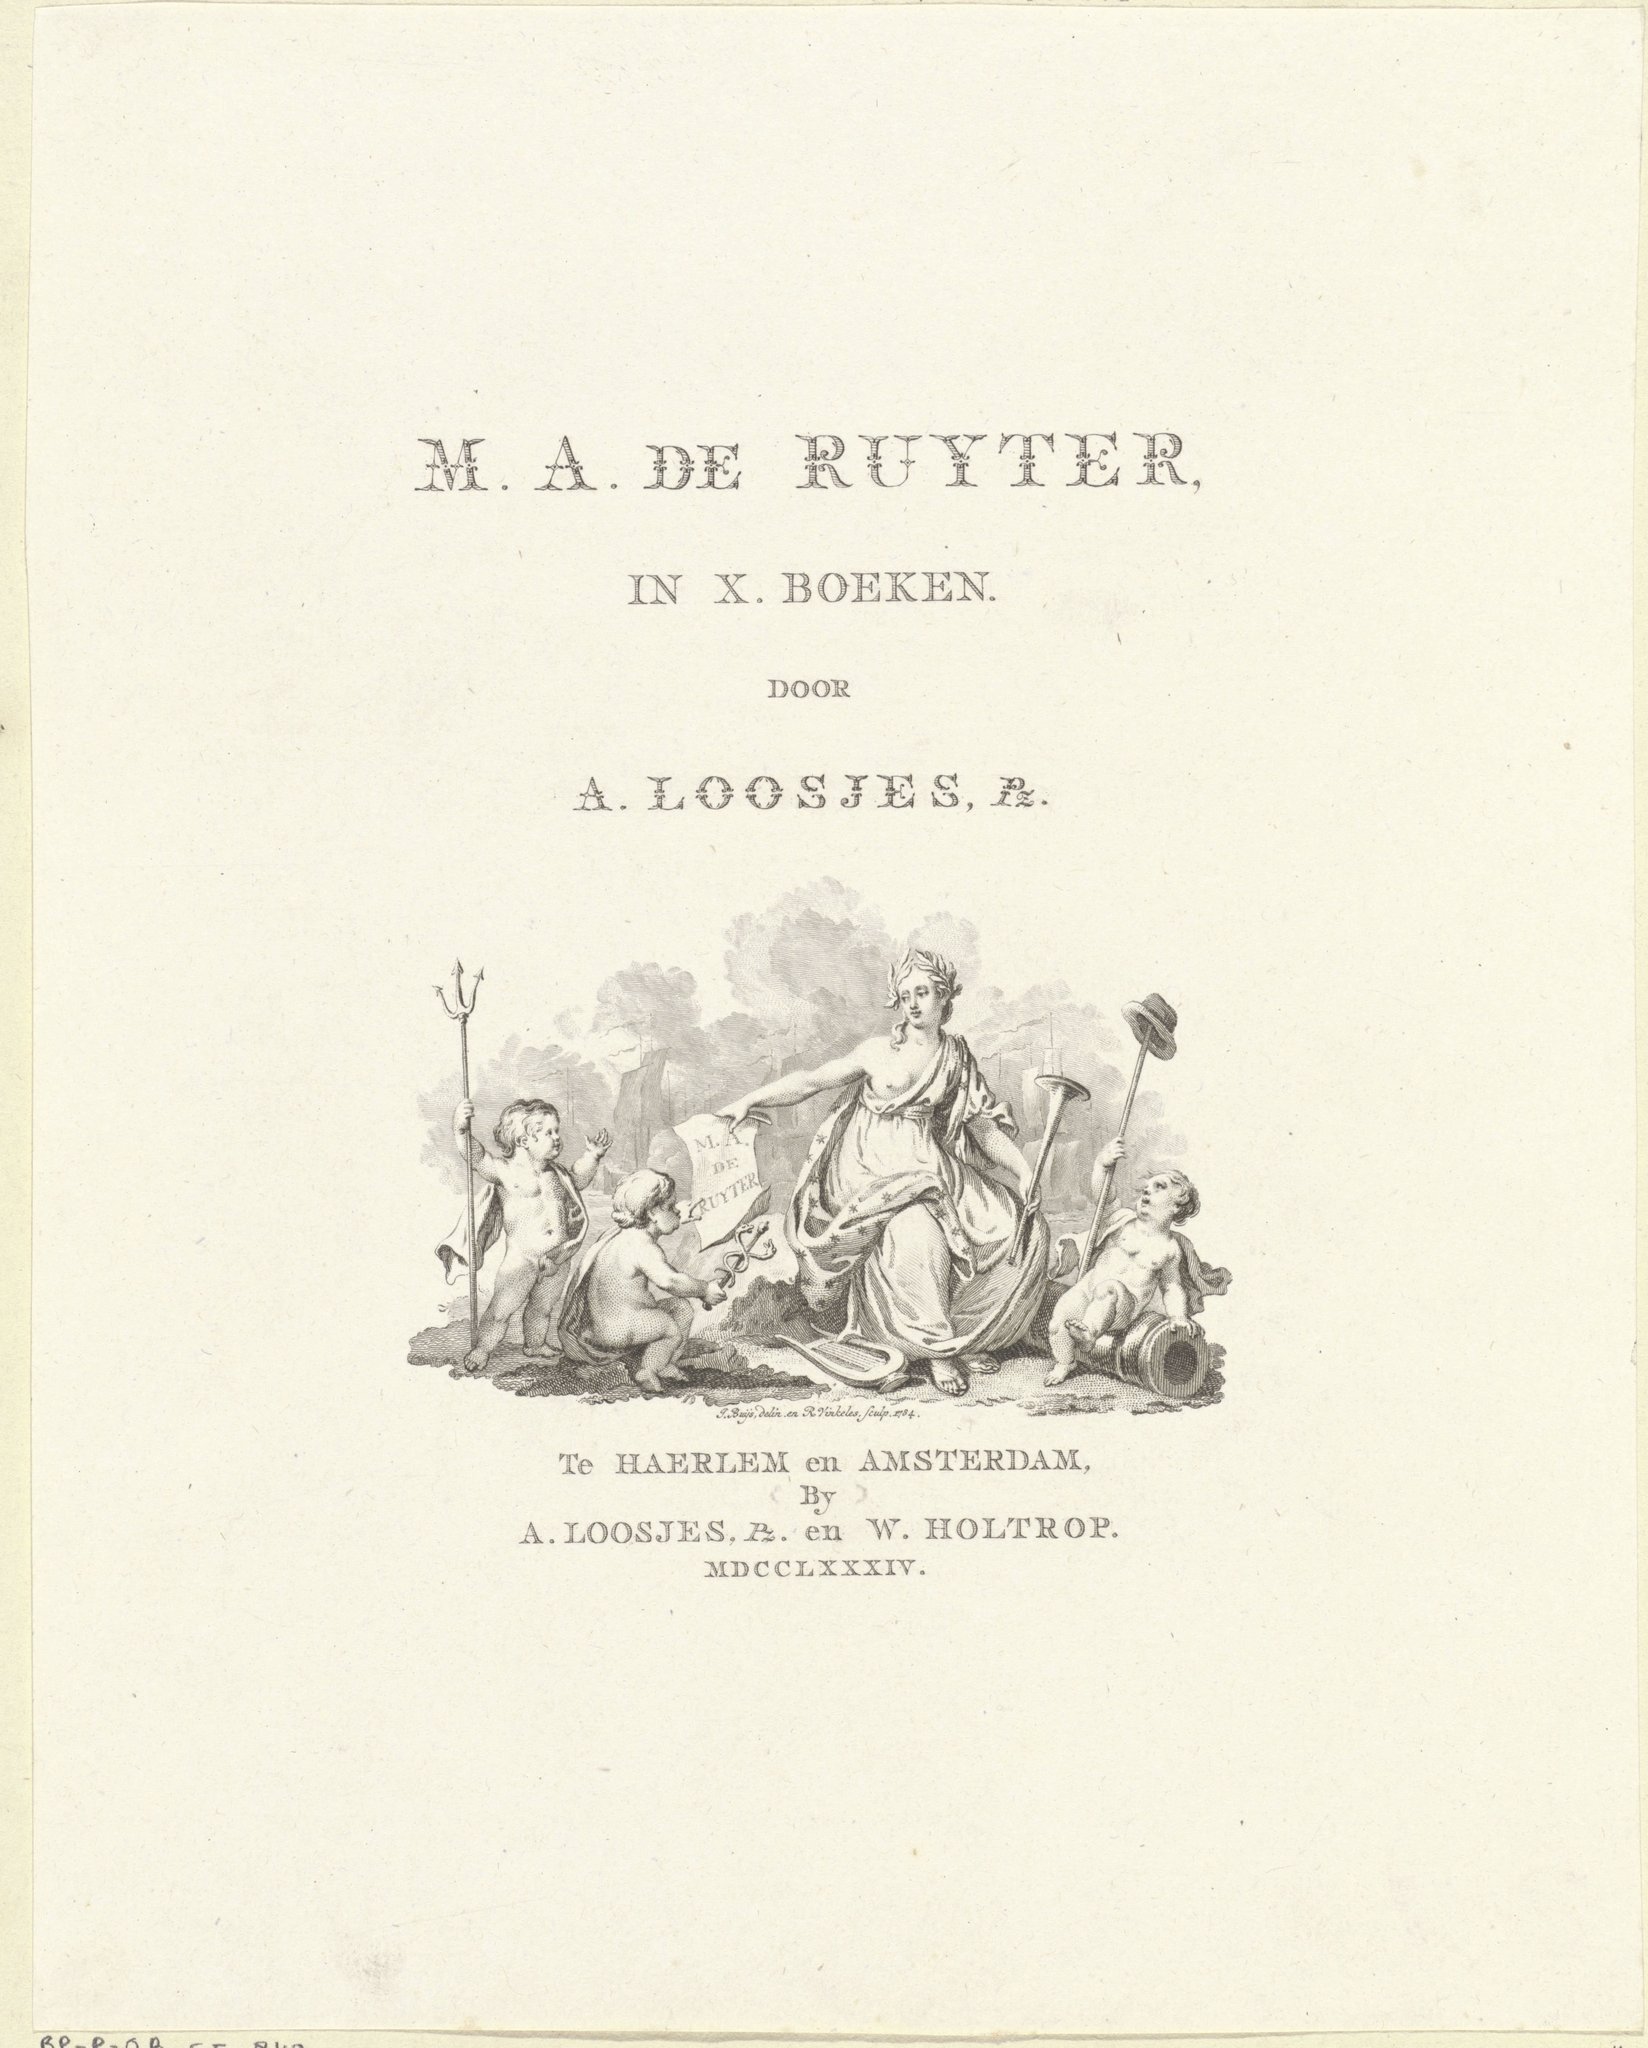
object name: titelblad, titelpagina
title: Titelpagina voor: Adriaan Pietersz. Loosjes., 'M.A. De Ruyter, in X Boeken', 1784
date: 1784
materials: paper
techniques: engraving, etching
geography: amsterdam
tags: flushing, michiel adriaenszoon de ruyter, sailing-ship, sailing-boat, attributes of mercury, cupids: 'amores', 'amoretti', 'putti', freedom, liberty; 'libertà' (ripa) (+ symbolical representation of concept)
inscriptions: collector's mark: Lugt 240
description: Titelpagina voor: Loosjes, Adriaan Pietersz.. M.A. De Ruyter, in X Boeken. Amsterdam: Willem Holtrop, Haarlem: Adriaan Pietersz. Loosjes, 1784.